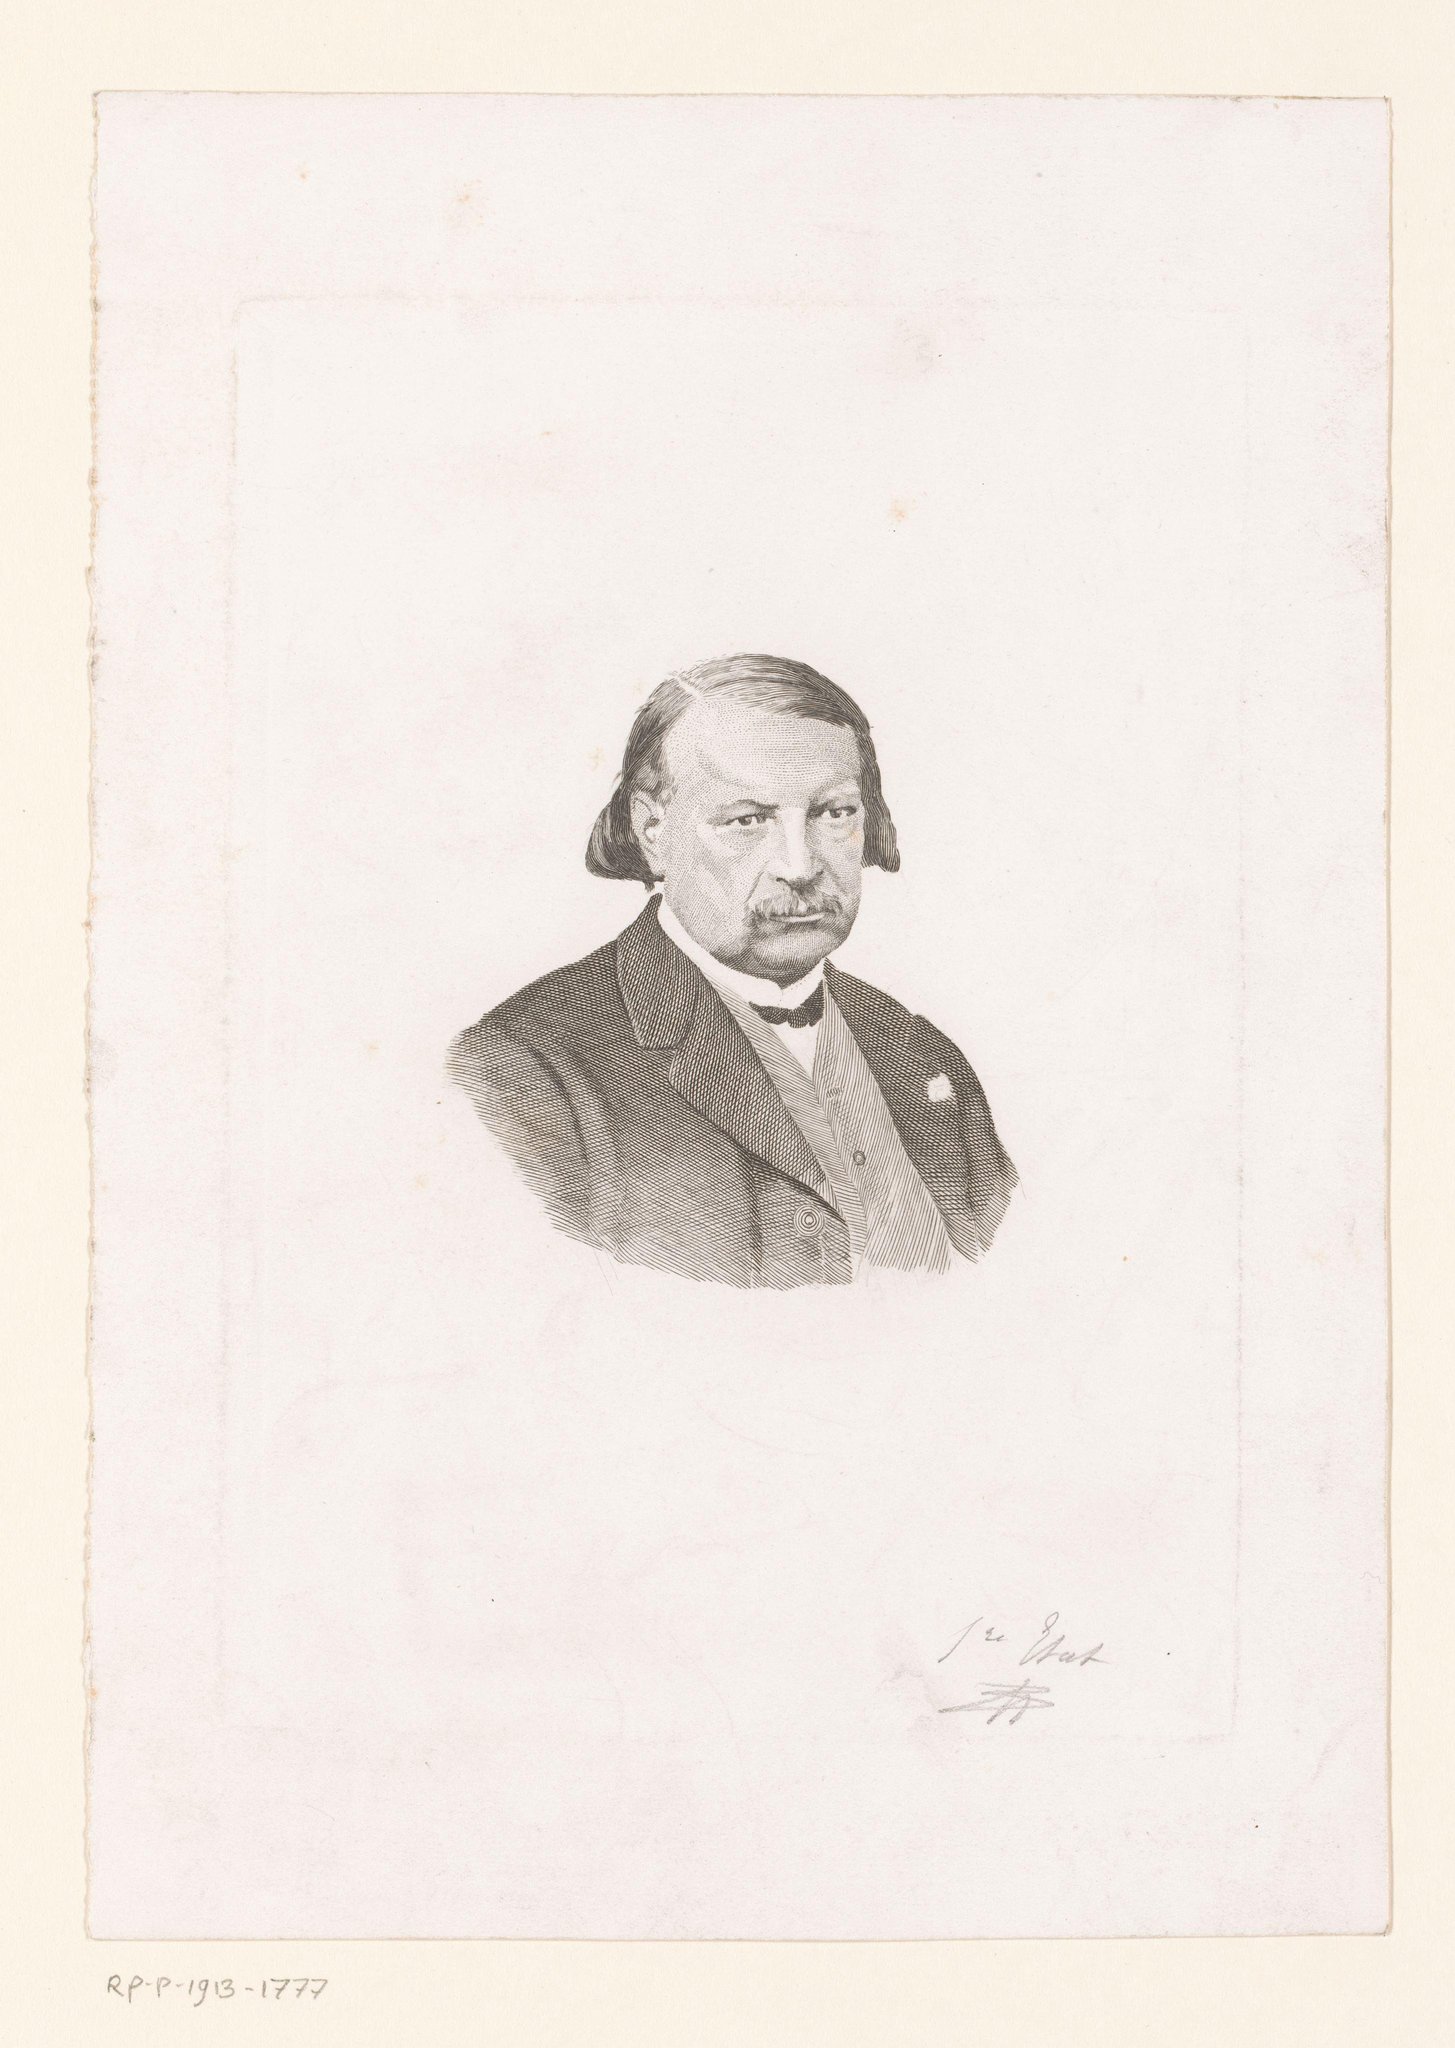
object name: print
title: Portret van Hendrik Conscience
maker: jean baptiste pierre michiels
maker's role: print maker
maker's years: 1821-1890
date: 1831-1890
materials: paper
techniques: etching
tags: adult man, historical persons, writer, poet, author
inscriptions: collector's mark: Lugt 2228, inscription: ‘1e Etat’